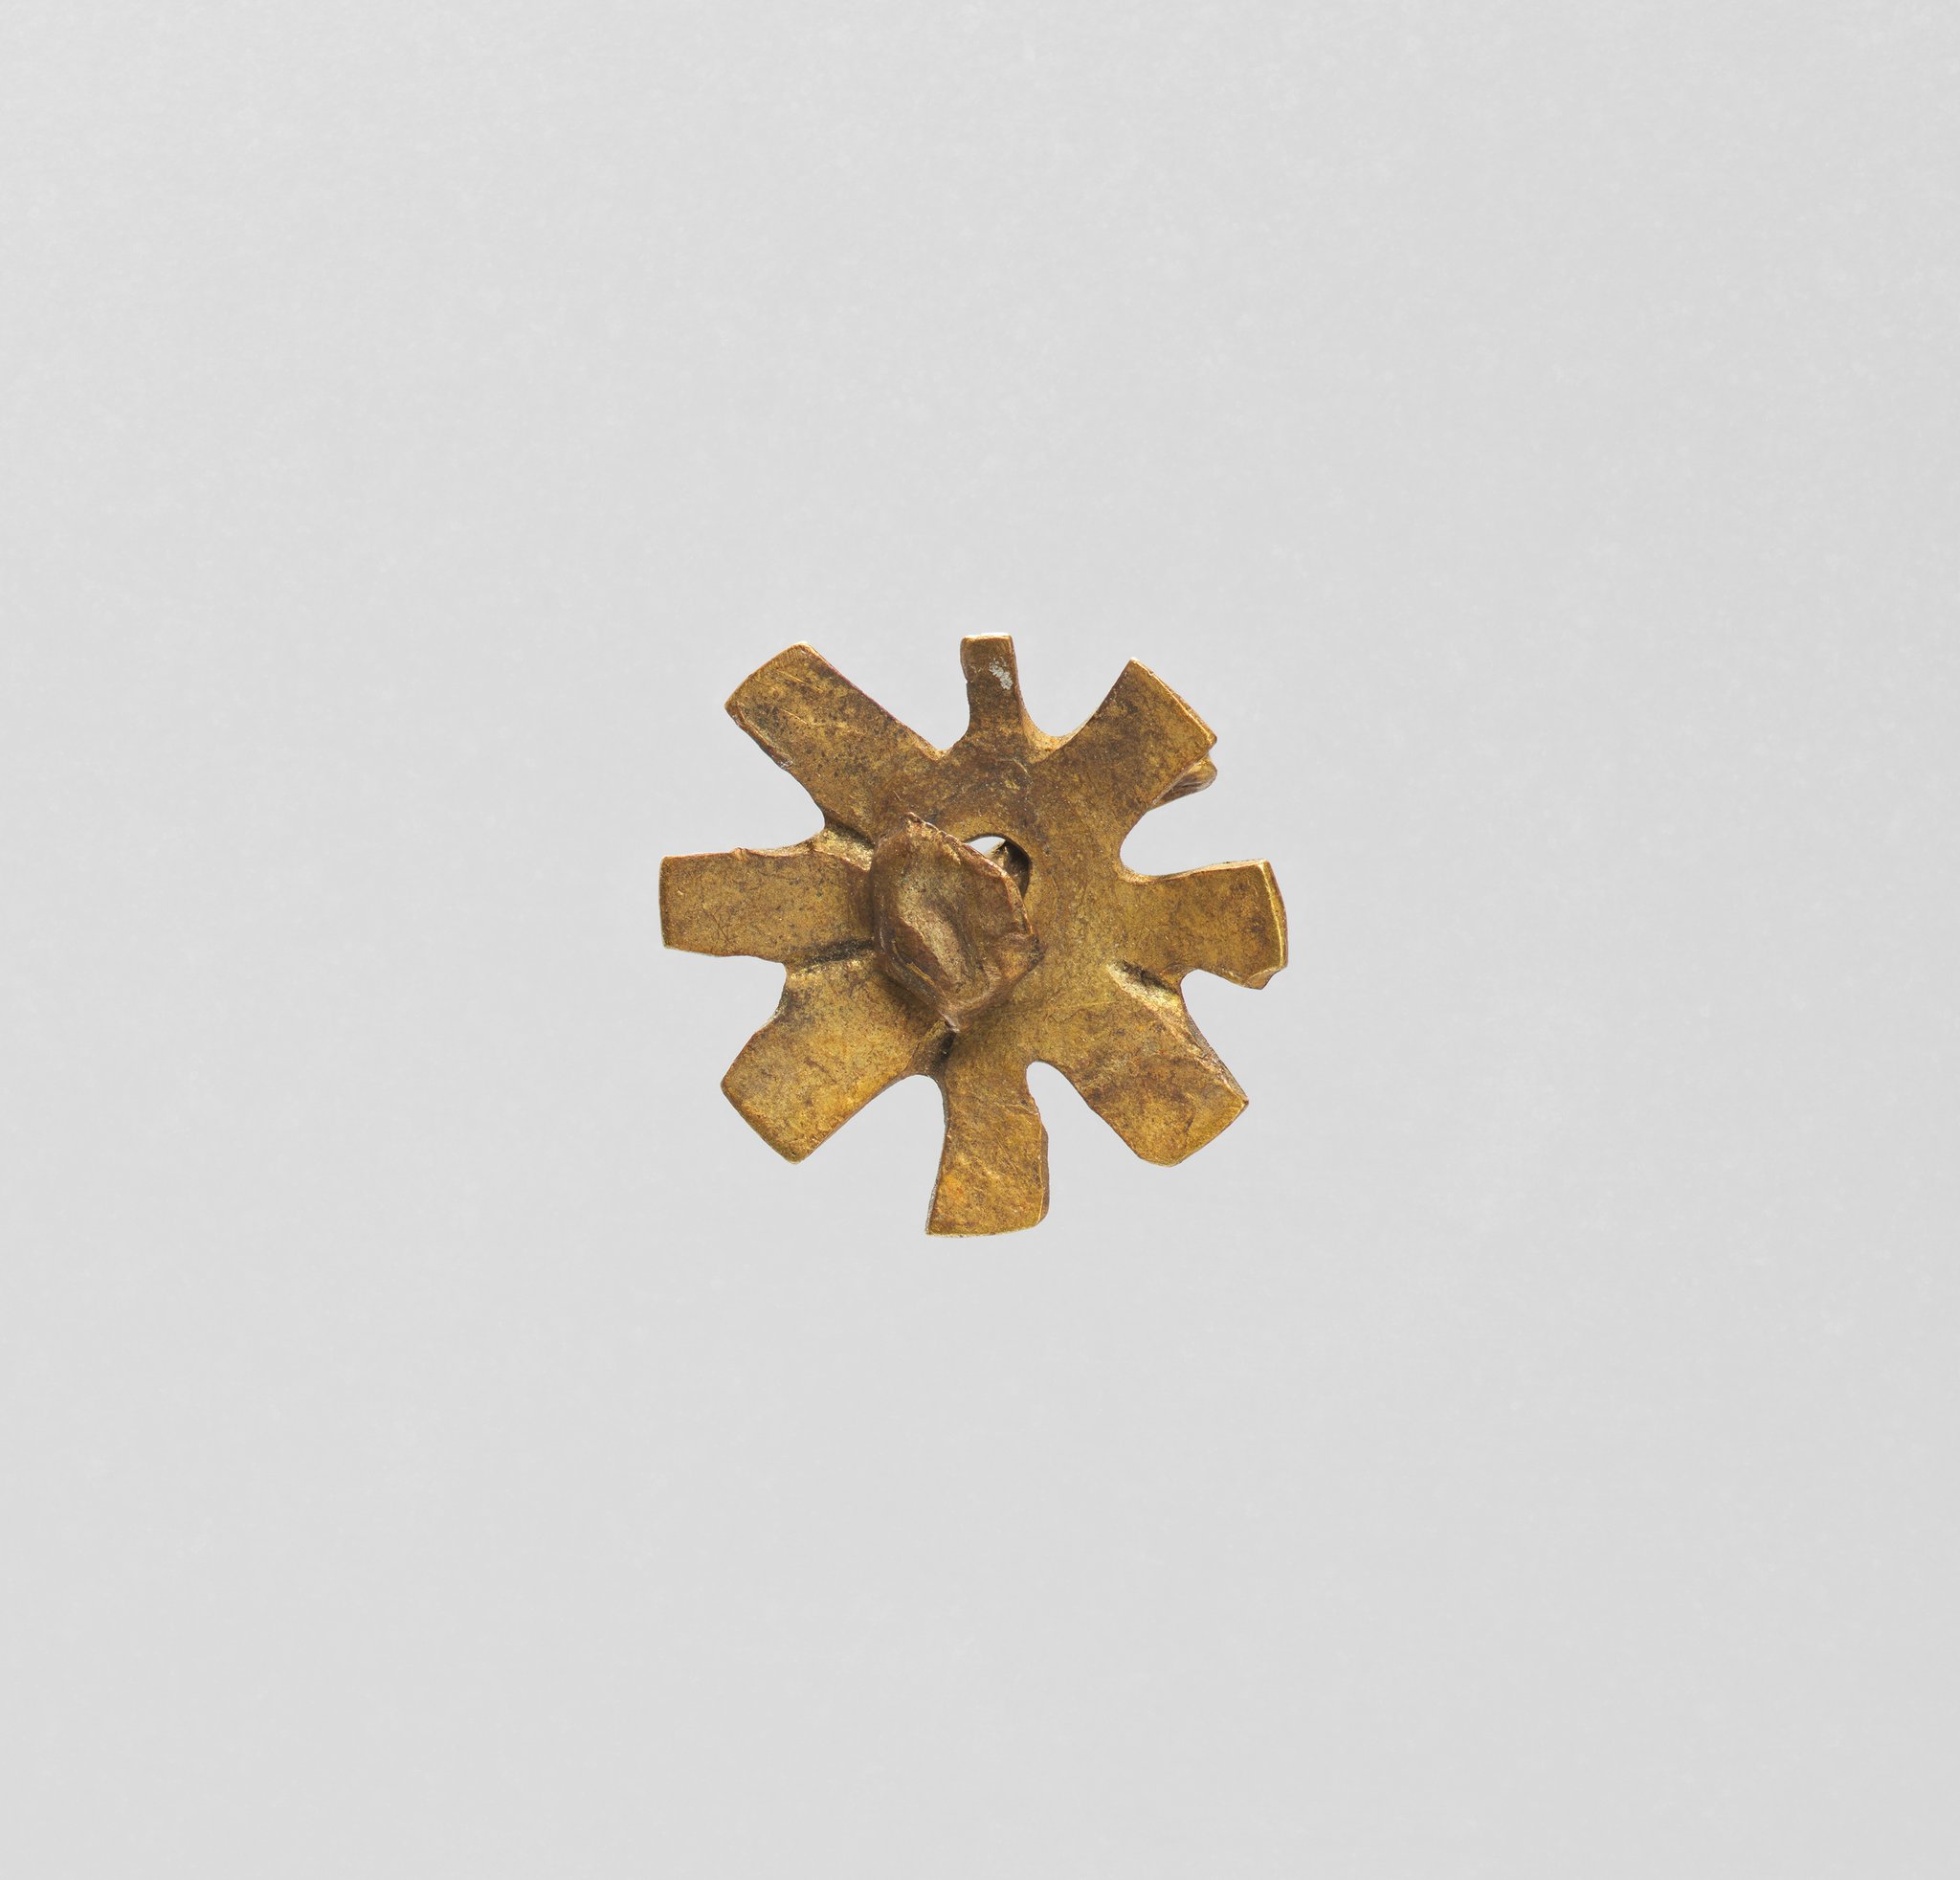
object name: pendant, rosette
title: Rosette Pendant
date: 1070-343 BCE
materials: gold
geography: egypt